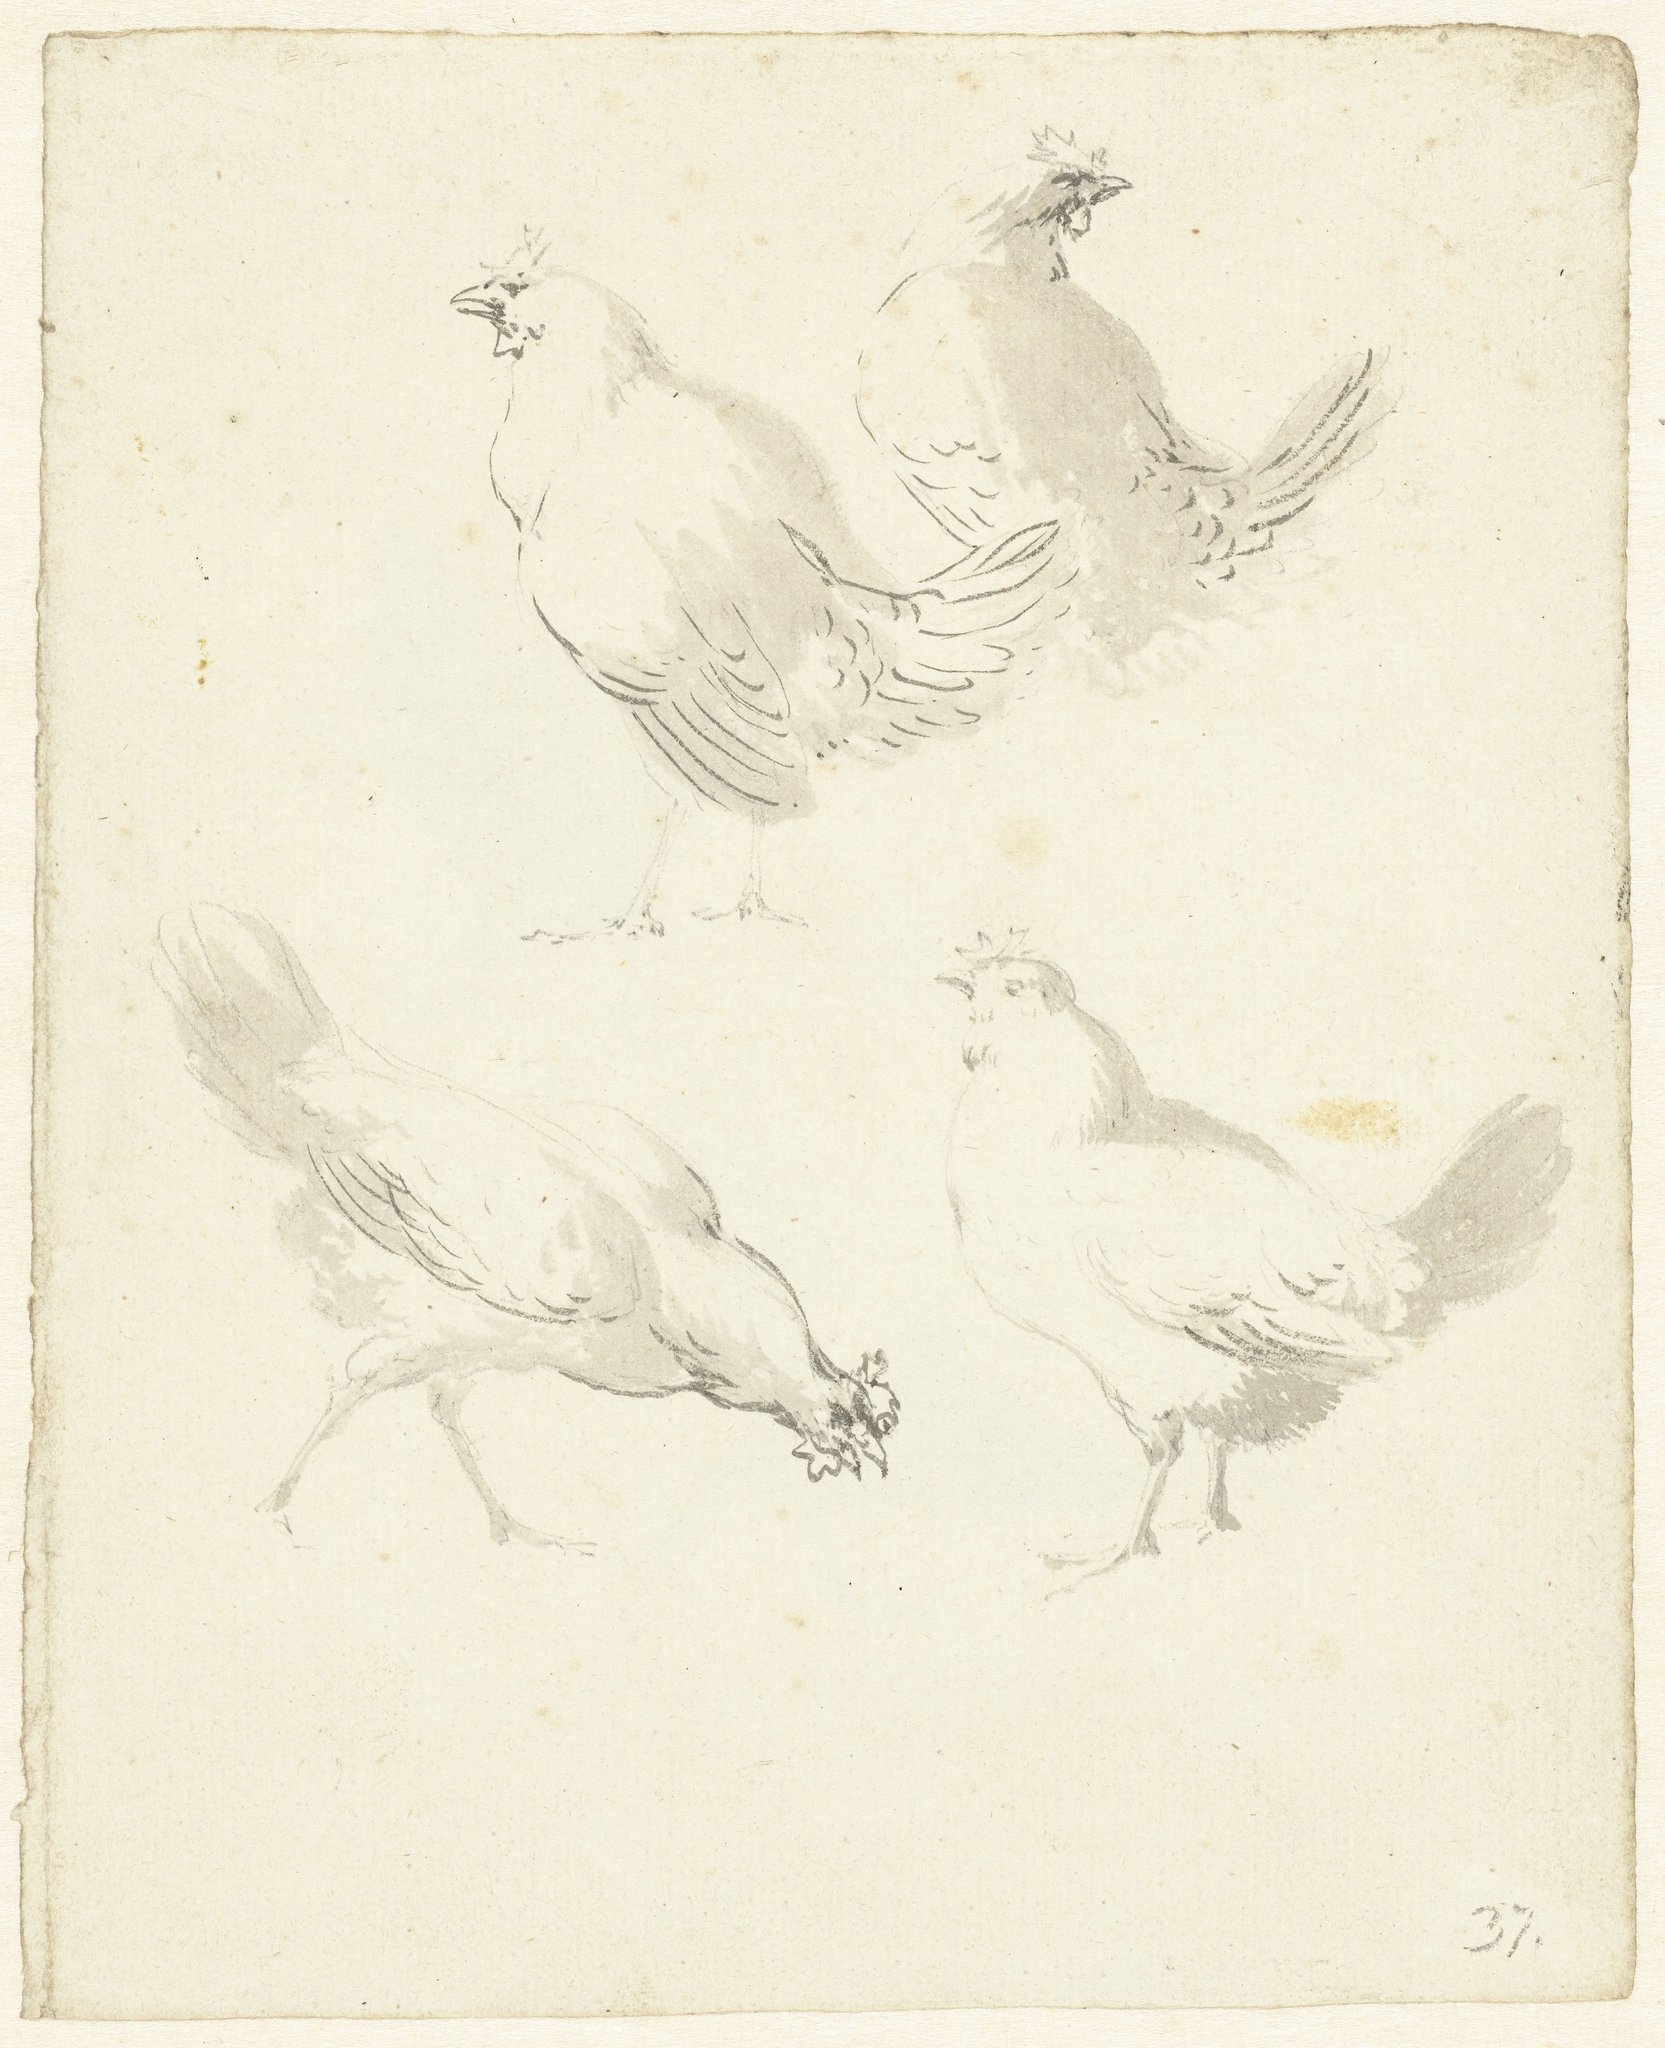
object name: drawing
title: Studieblad met vier kippen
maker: aert schouman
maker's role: draughtsman, painter, print maker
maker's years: 1710-1792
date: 1720-1792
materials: ink, paper, pencil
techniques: brush, pen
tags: fowl (cock, hen, chicken, etc.) (+ female animal)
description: Studieblad met vier kippen, verso: twee kippen.